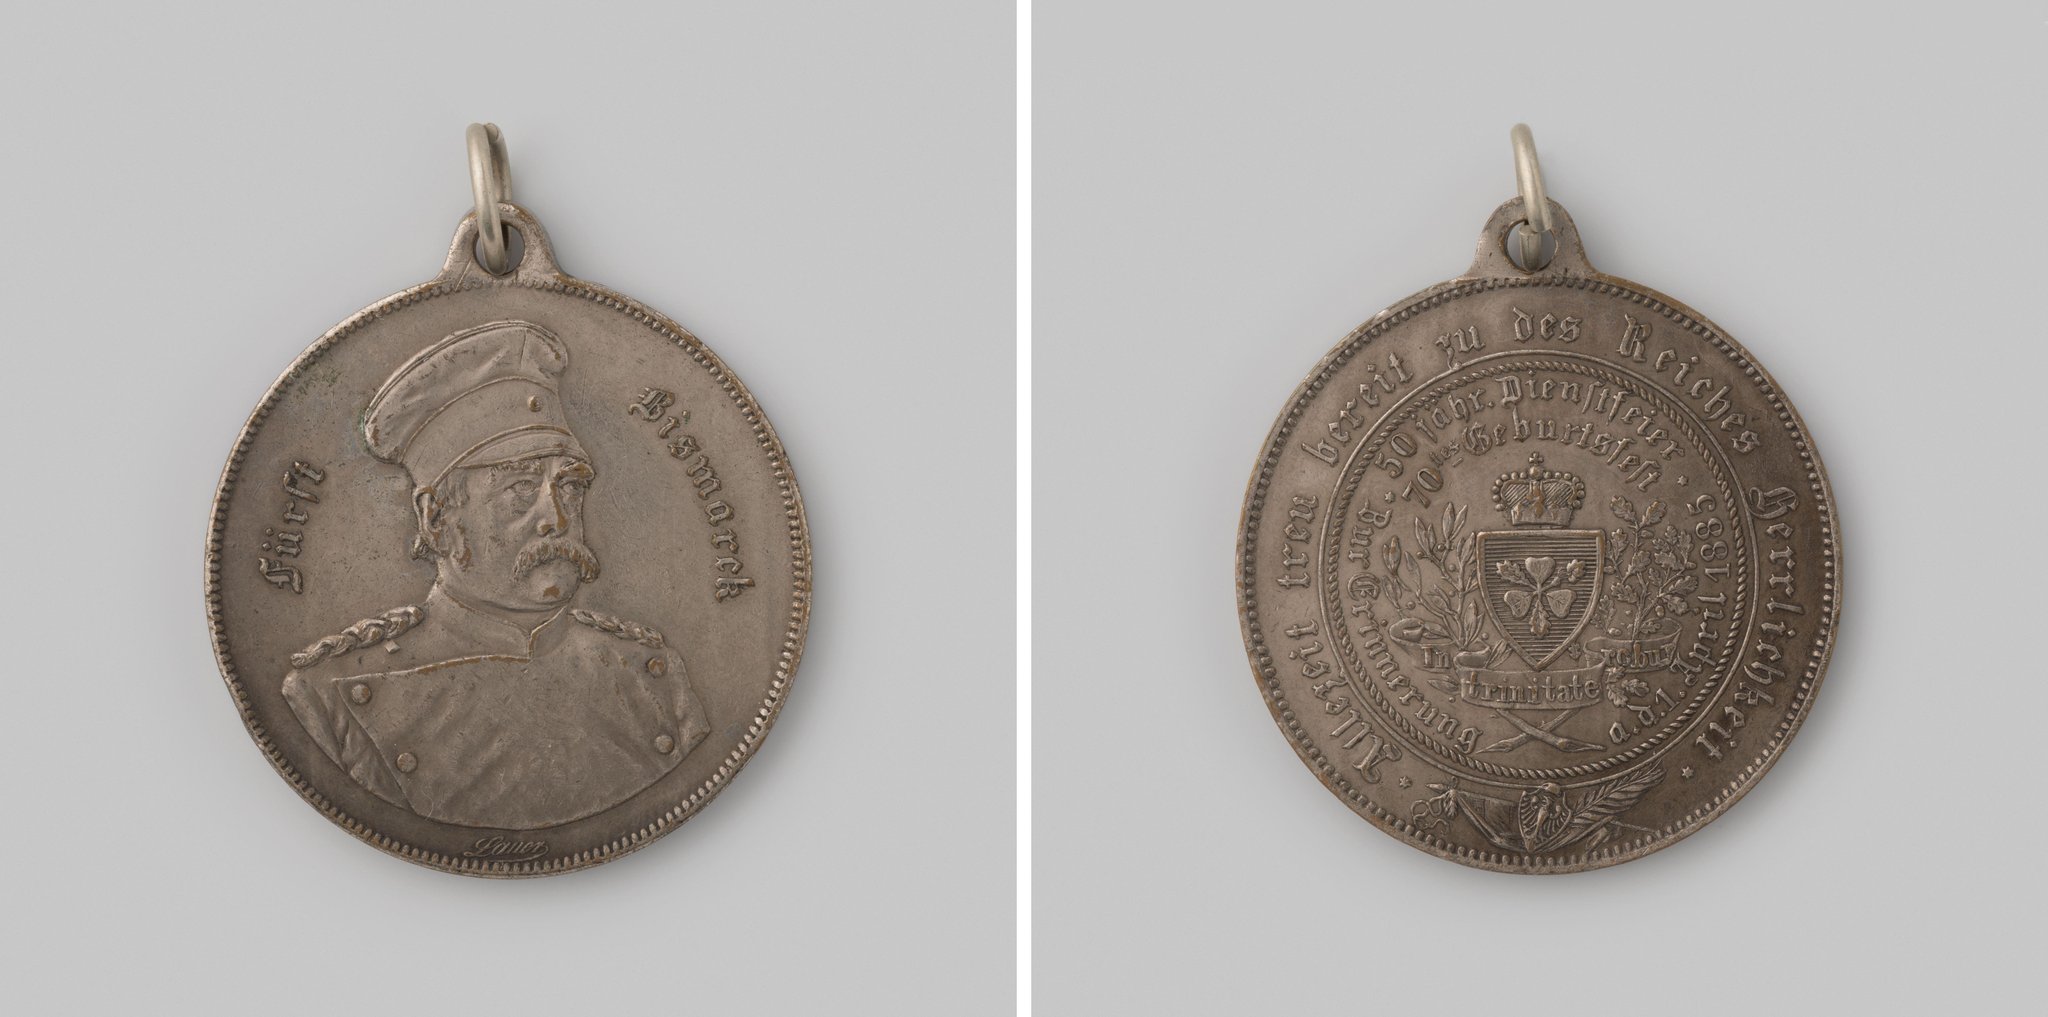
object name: history medal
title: Zeventigste verjaardag van Fürst Otto von Bismarck 1885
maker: wolfgang lauer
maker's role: medailleur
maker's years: 1856-1915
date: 1885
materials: brass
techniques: striking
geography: nuremberg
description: Verzilverde penning met oog en draagring, op de voorzijde het borstbeeld van Bismarck half naar rechts met omschrift, op de keerzijde een gekroond wapenschild op banderol tussen gekruiste lauwer- en eikentakken, met dubbel omschrift, binnen een cirkel, waarbuiten een omschrift met onderaan een wapenschild, vaandel en lauwertak.